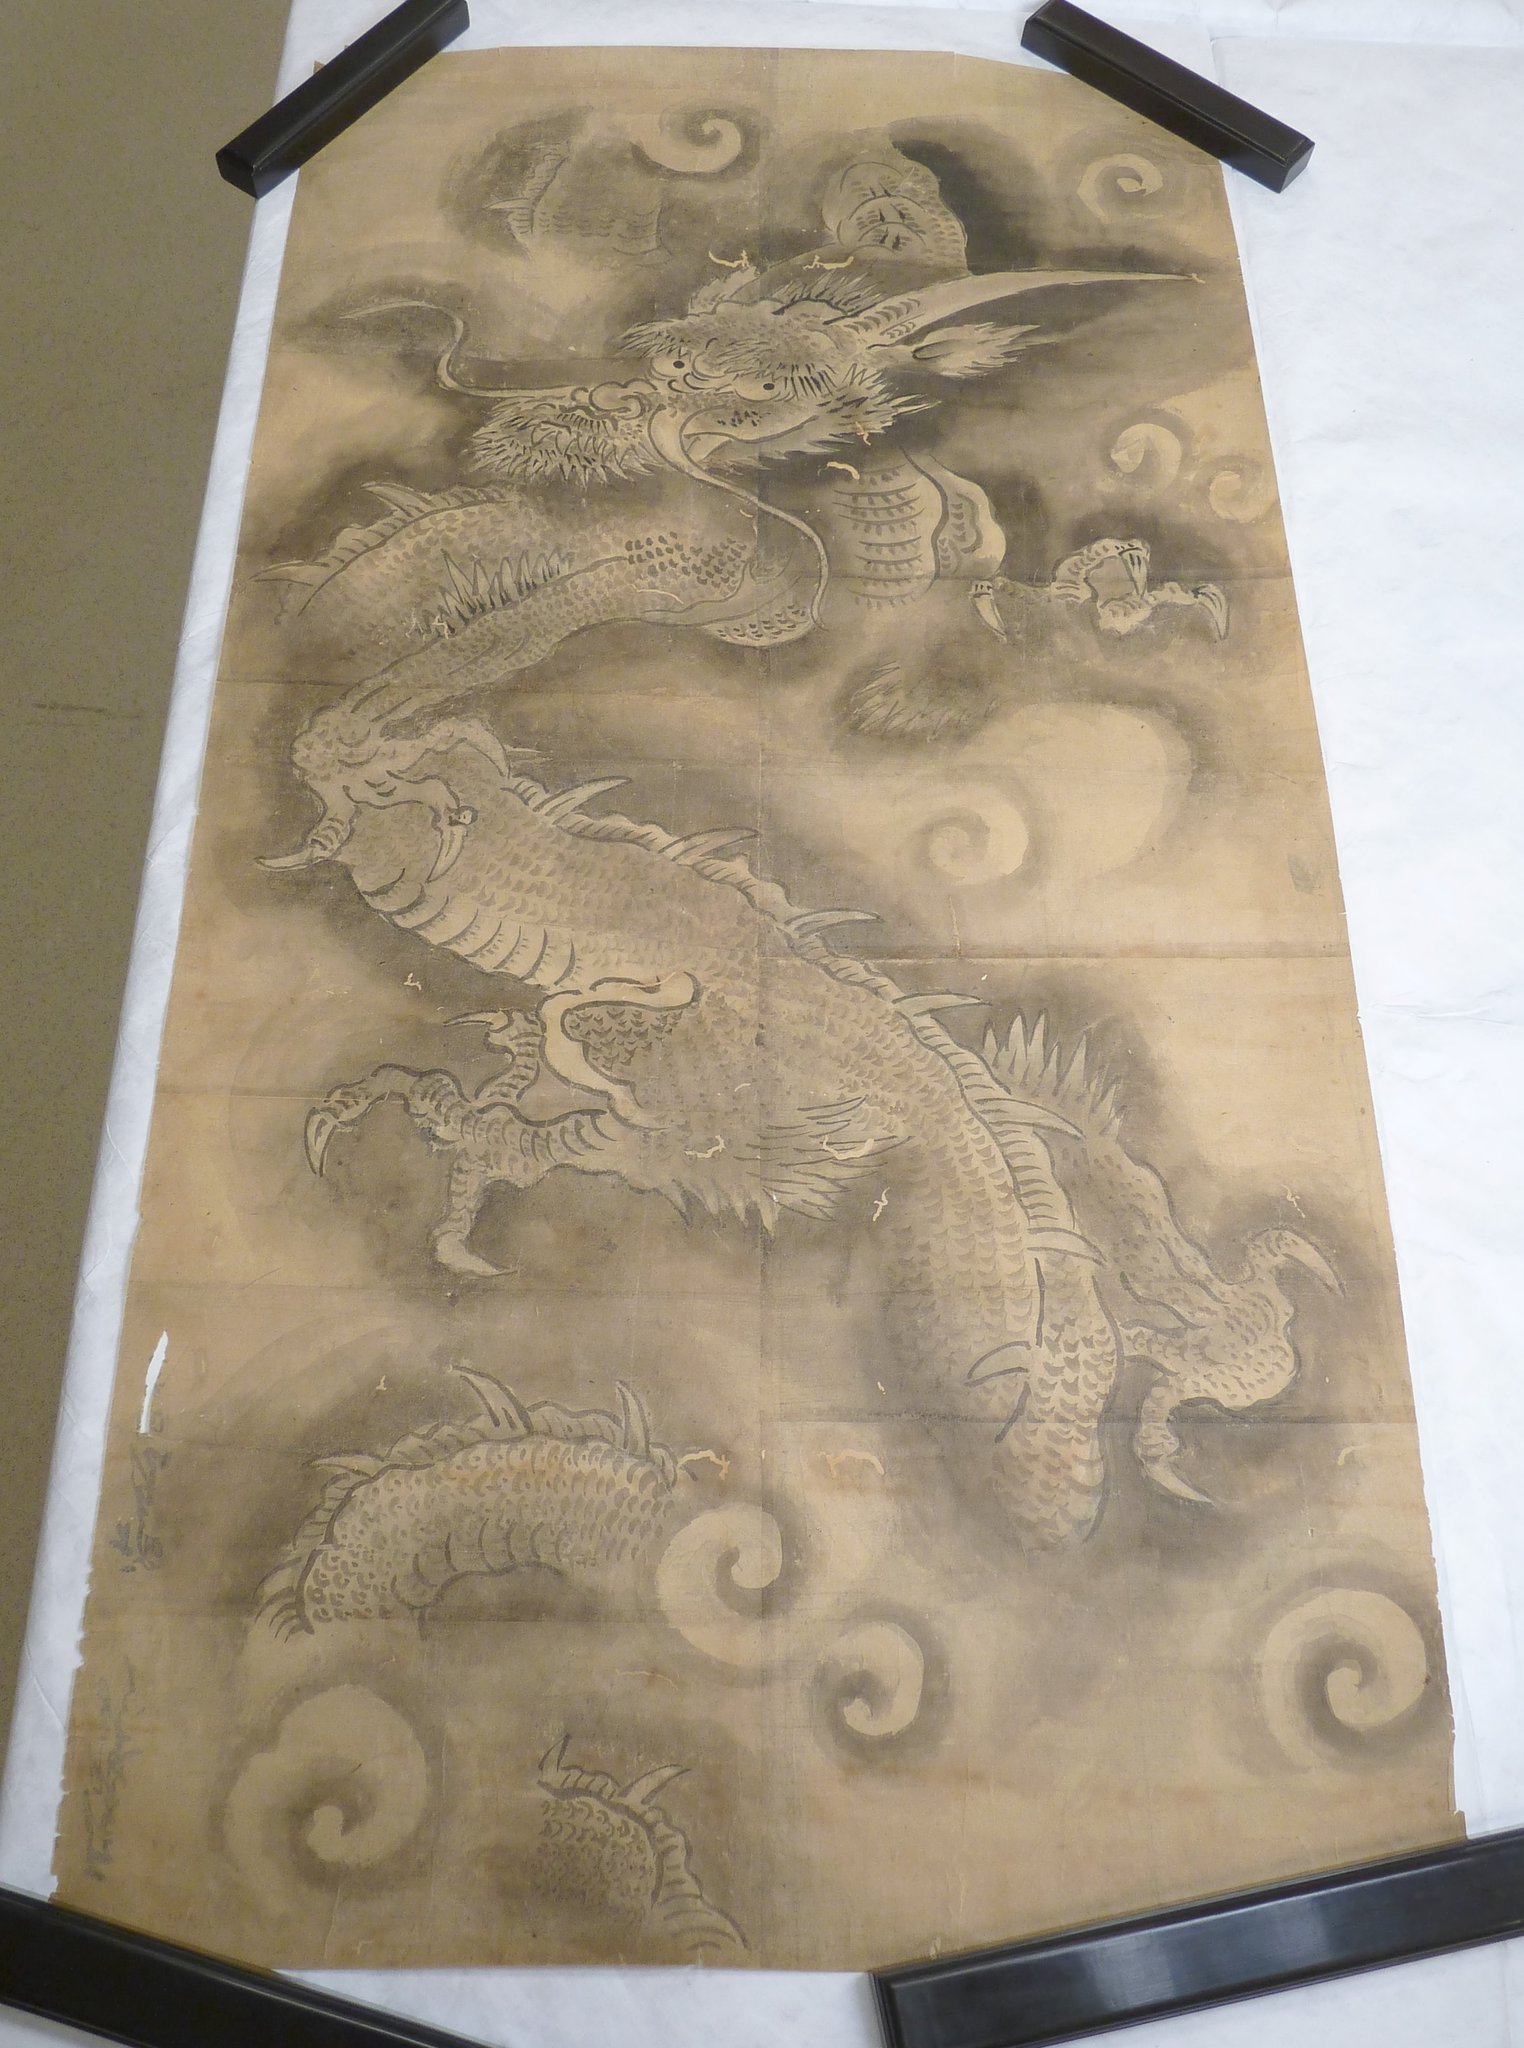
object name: drawing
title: Japanese Drawing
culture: japanese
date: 1801-1833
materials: paper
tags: dragons